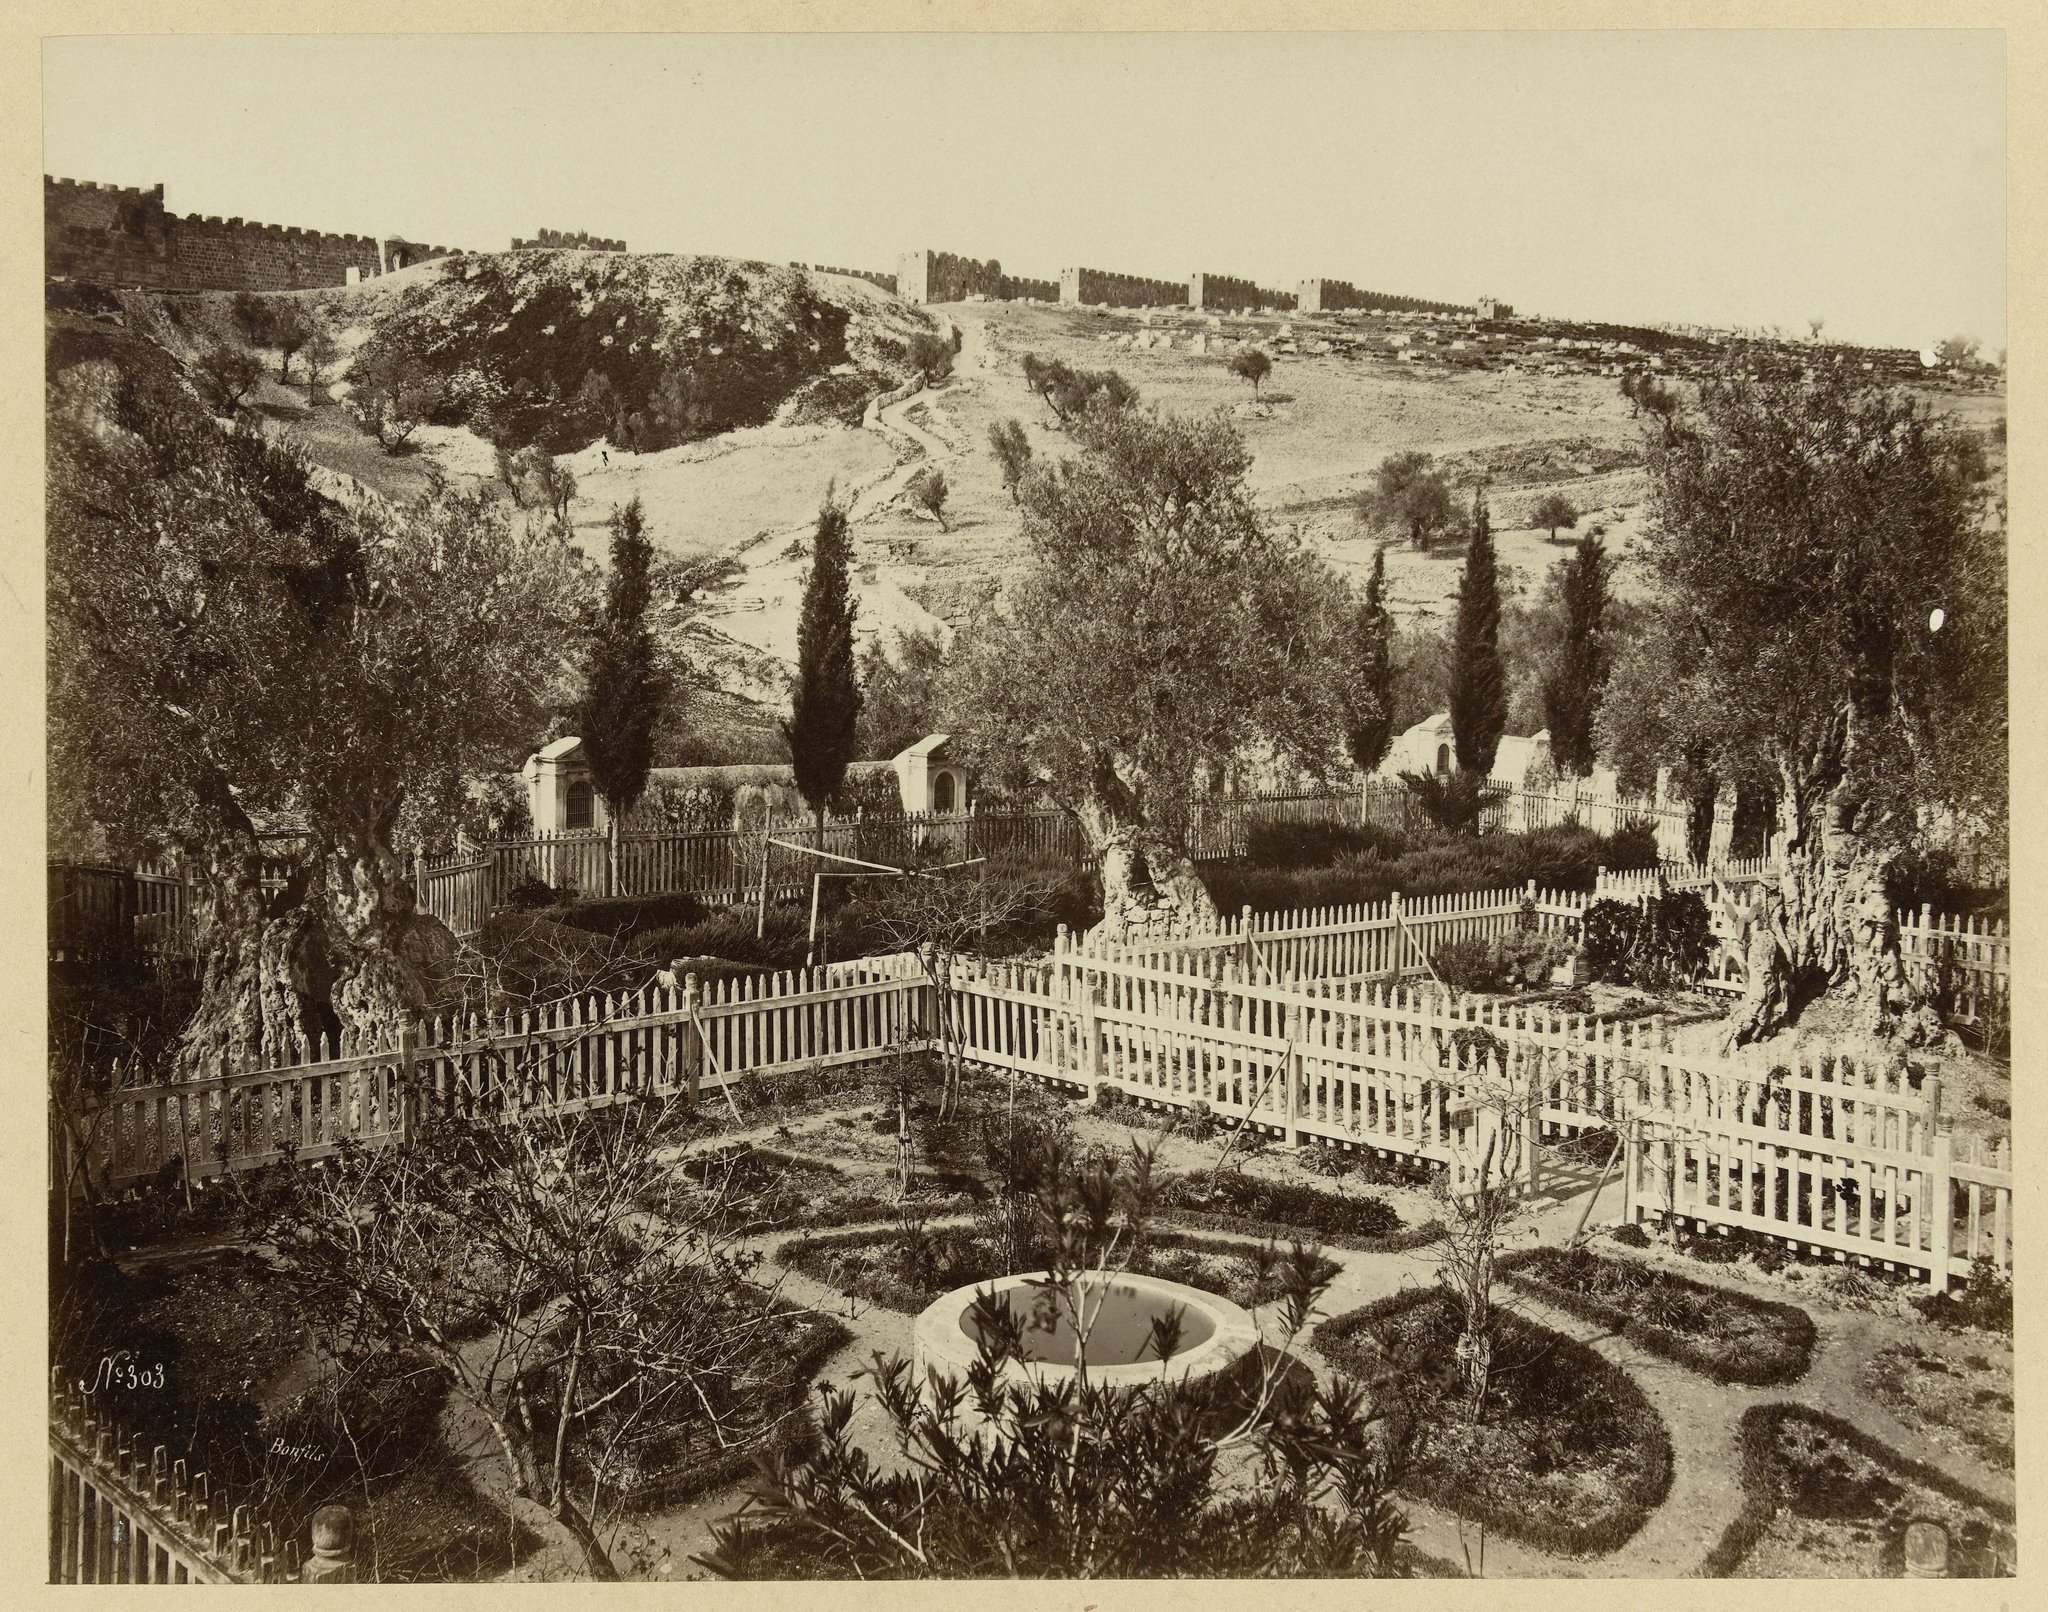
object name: photograph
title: Gezicht op de tuin van Getsemane, Jeruzalem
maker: félix bonfils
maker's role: fotograaf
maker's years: 1831-1885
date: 1867-1877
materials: cardboard, paper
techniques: albumen print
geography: jerusalem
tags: garden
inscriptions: stamp: ‘Gemeentelijke bibliotheek/ Rotterdam’, number: ‘No 303’, title: ‘S 41. De tuin Gethsemane (van den muur van Jeruzalem gezien).’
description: Onderdeel van een groep door fotograaf Richard Polak op reis verzamelde foto’s. Deze foto is samen met andere op zijn reizen verzamelde foto's tentoongesteld bij de Rotterdamsche Kunstkring (1895), Arti en Amicitiae te Amsterdam (1897-1898?) en Societeit 't Collegie te Kampen (datum vooralsnog onbekend).